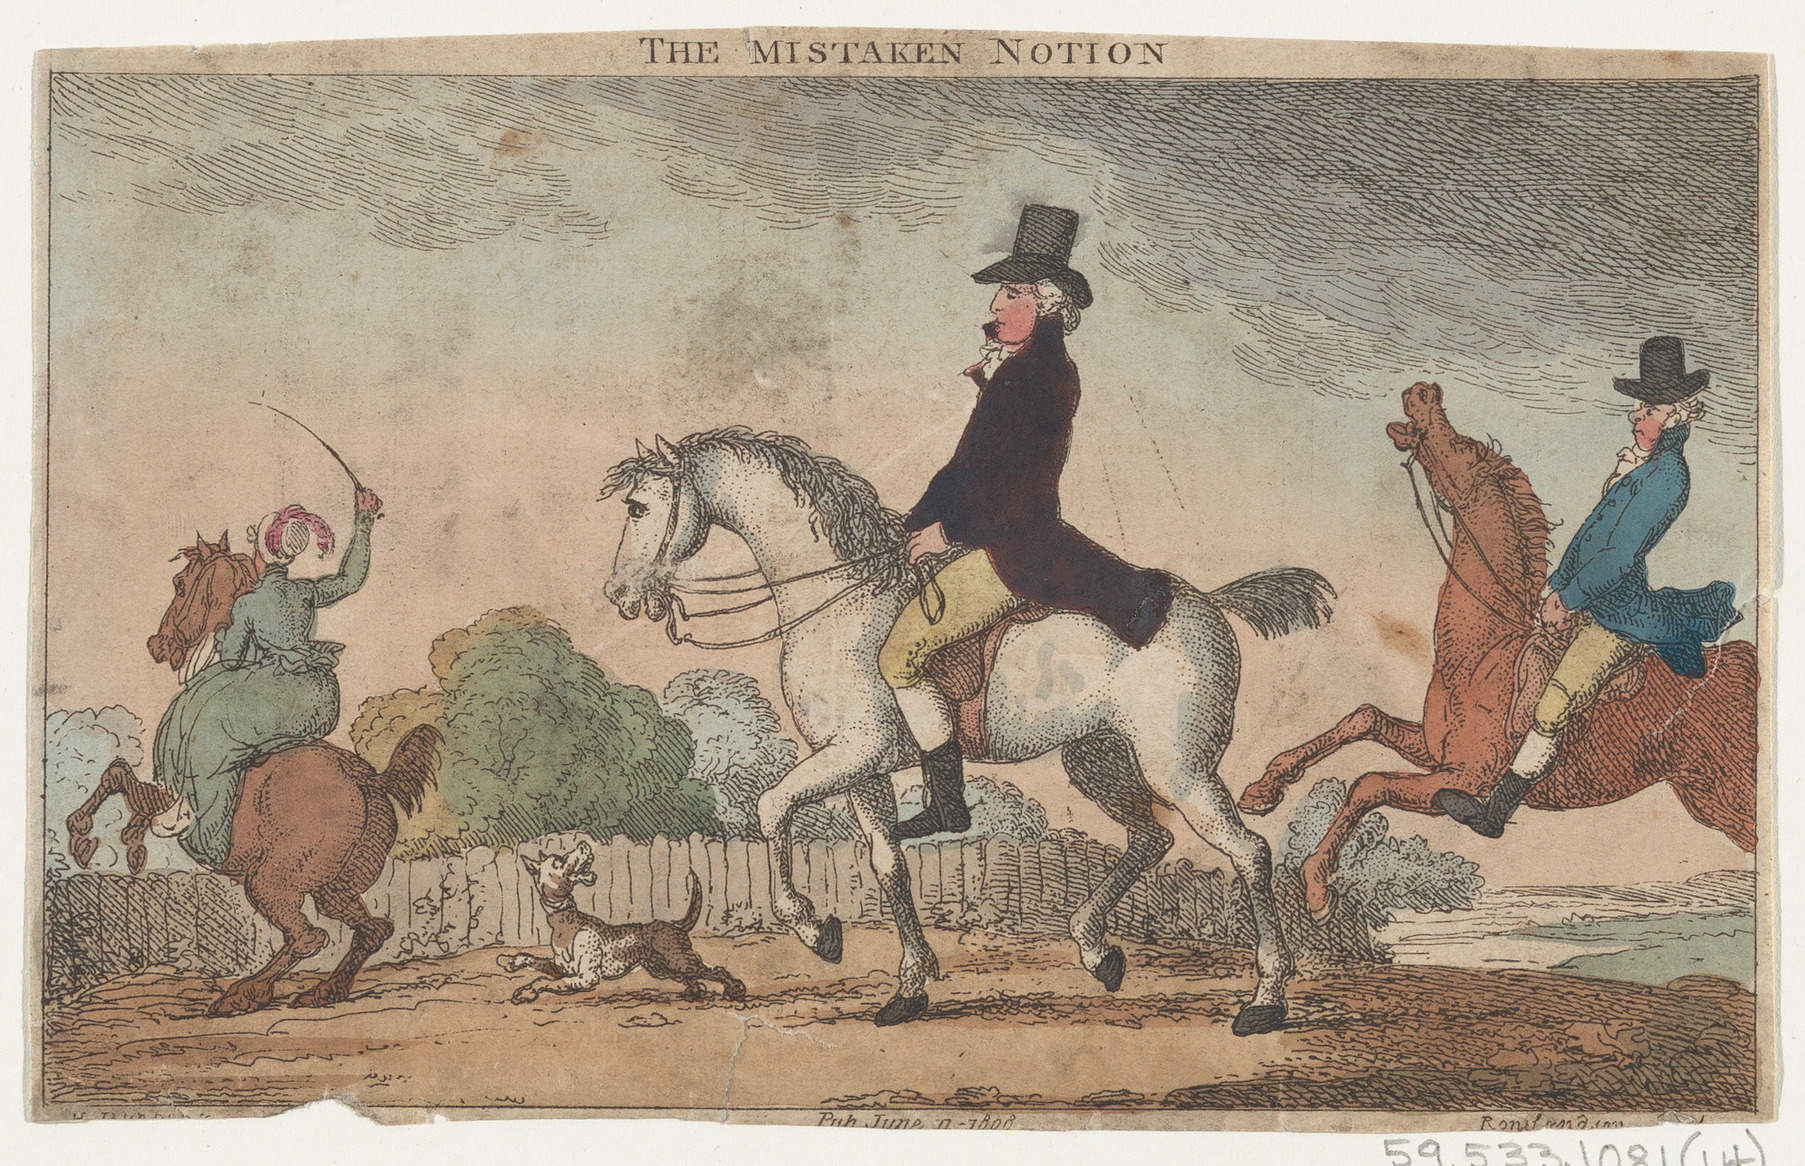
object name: print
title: The Mistaken Notion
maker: thomas rowlandson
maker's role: artist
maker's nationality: british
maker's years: 1757-1827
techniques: etching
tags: satire,men,dogs,horses